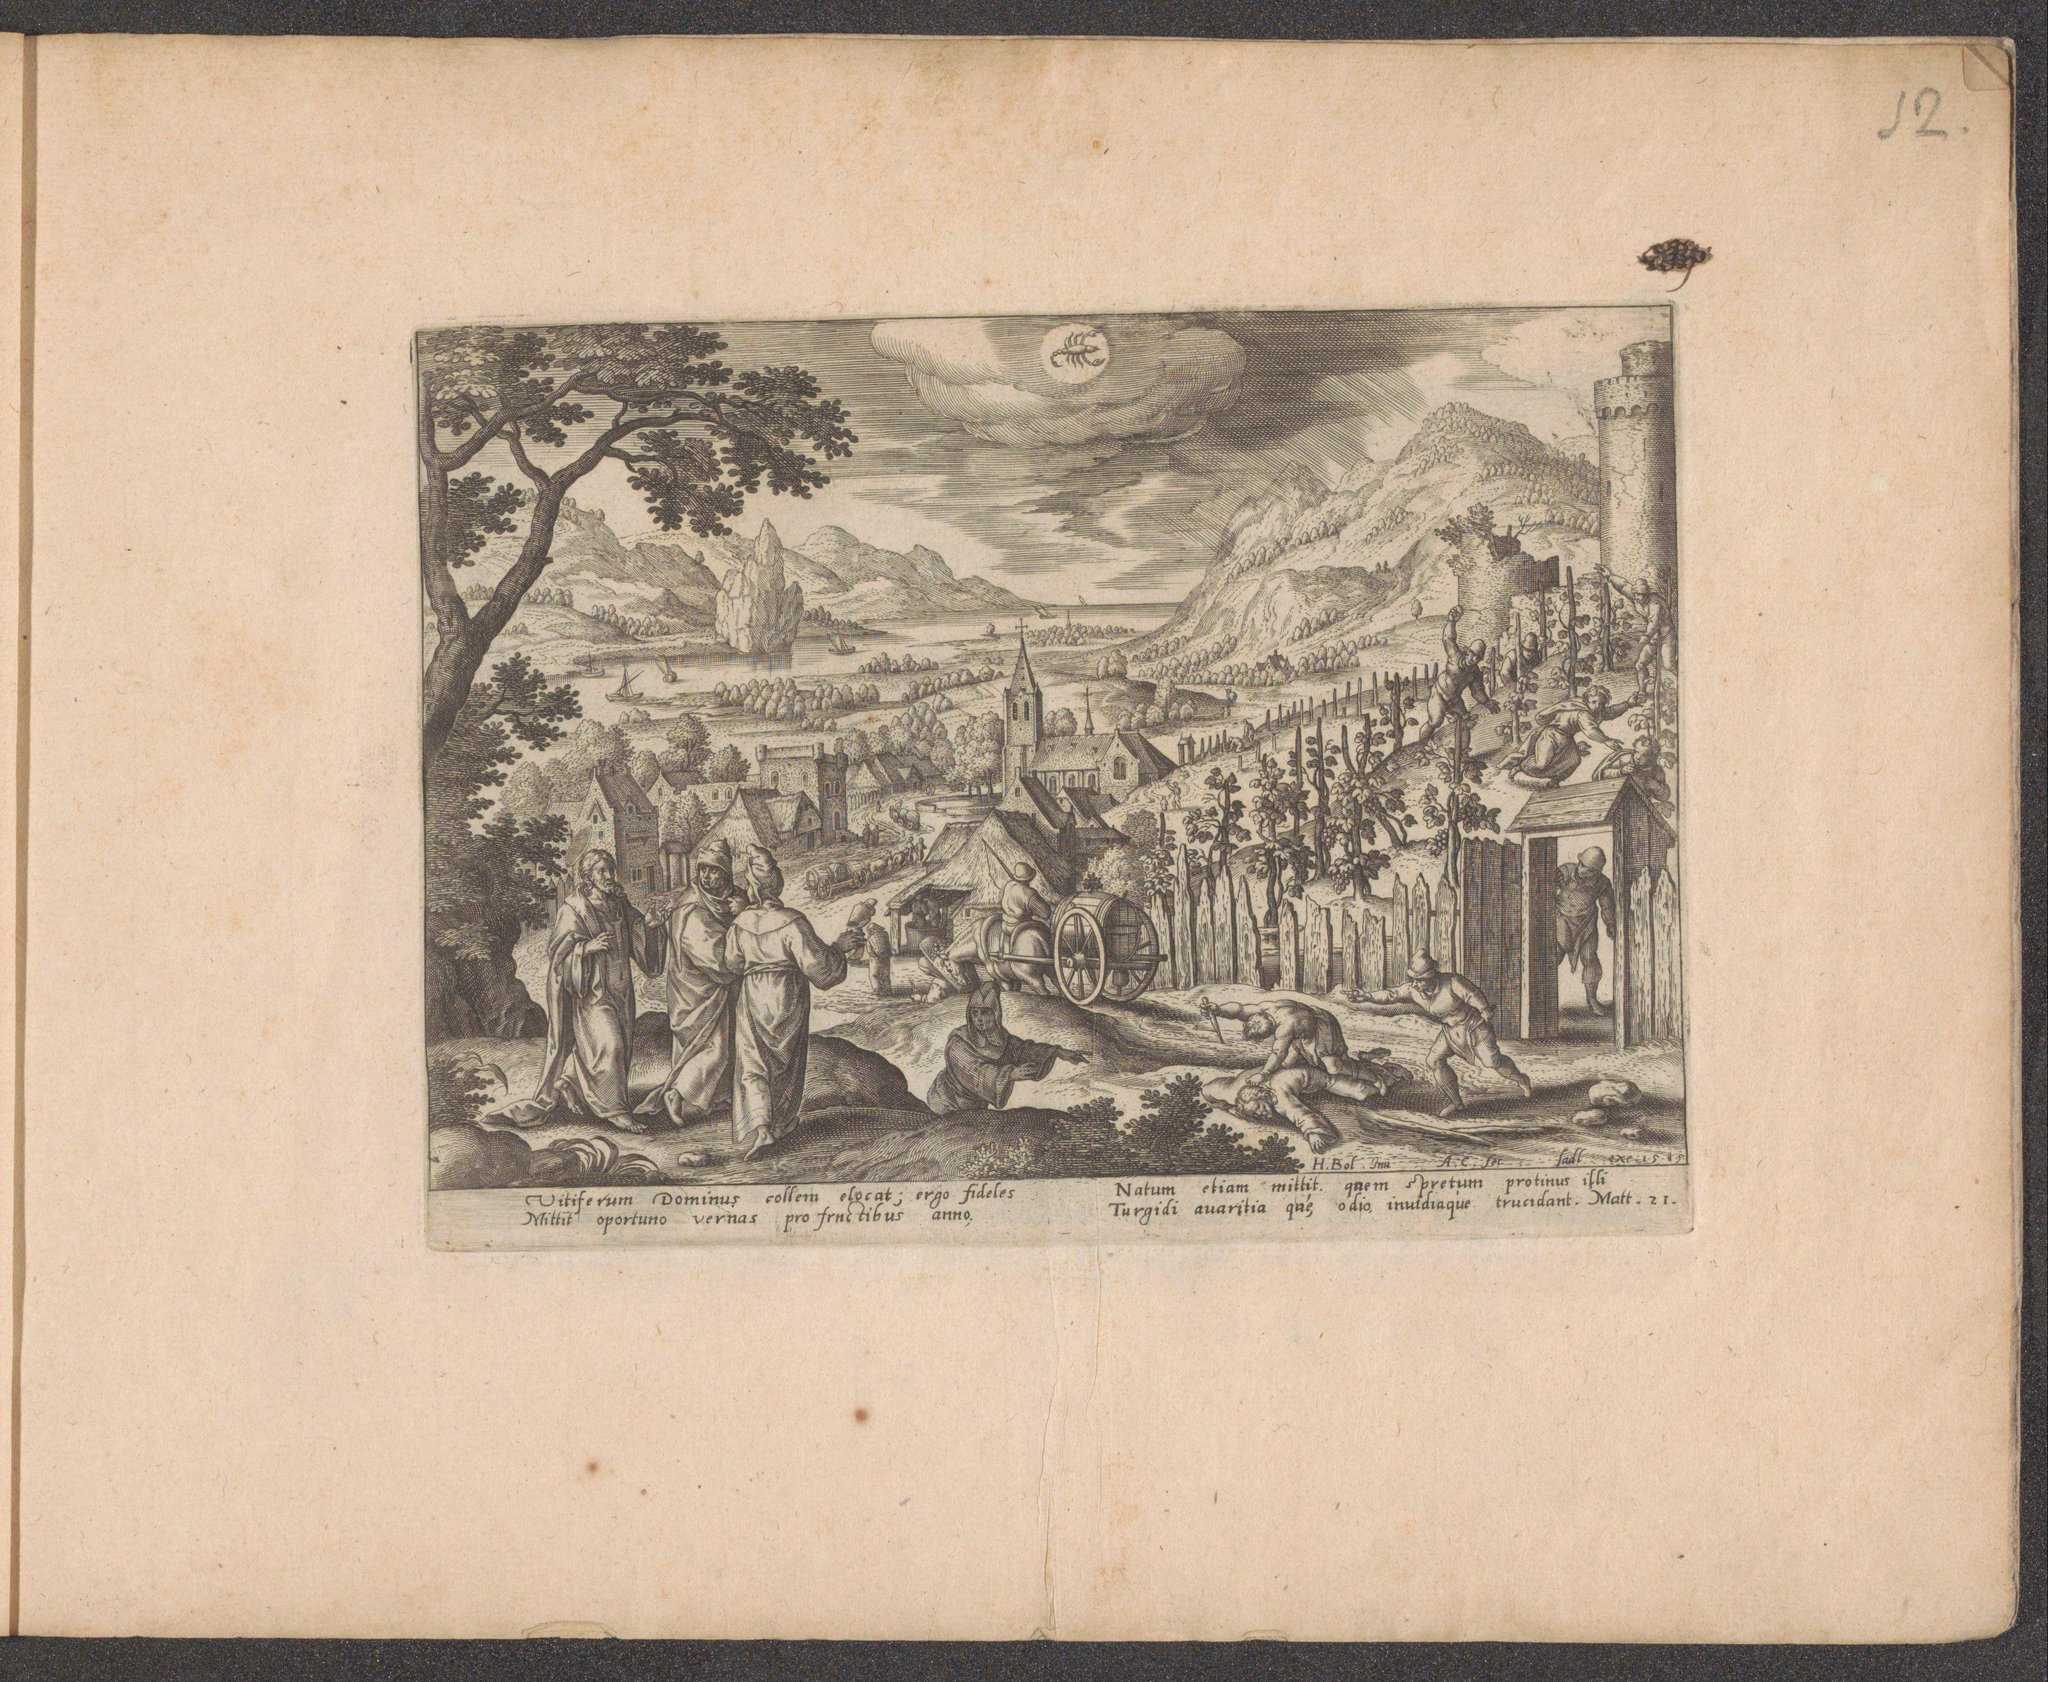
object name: album leaf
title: Oktober: Christus vertelt de apostelen de parabel van de boze wijngaardiers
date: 1585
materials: paper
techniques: engraving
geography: antwerp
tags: at last the lord sends his son, '... they cast him out of the vineyard, and killed him', landscape symbolizing october, vineyard, october ~ other concepts (+ with zodiacal signs), scorpio (zodiacal sign of october)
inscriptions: date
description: Middenboven het sterrenbeeld Schorpioen. Linksvoor staat Christus bij twee mannen. Hij wijst naar de scène rechts waar de zoon van de heer wordt vermoord door de boze wijngaardiers. Binnen de omheining de wijngaard waar de dienaren van de heer met stokken worden geslagen. Heuvelachtig landschap op de achtergrond. Onder de voorstelling vier regels Latijn in twee kolommen (Mat. 21). De prent maakt deel uit van een album.